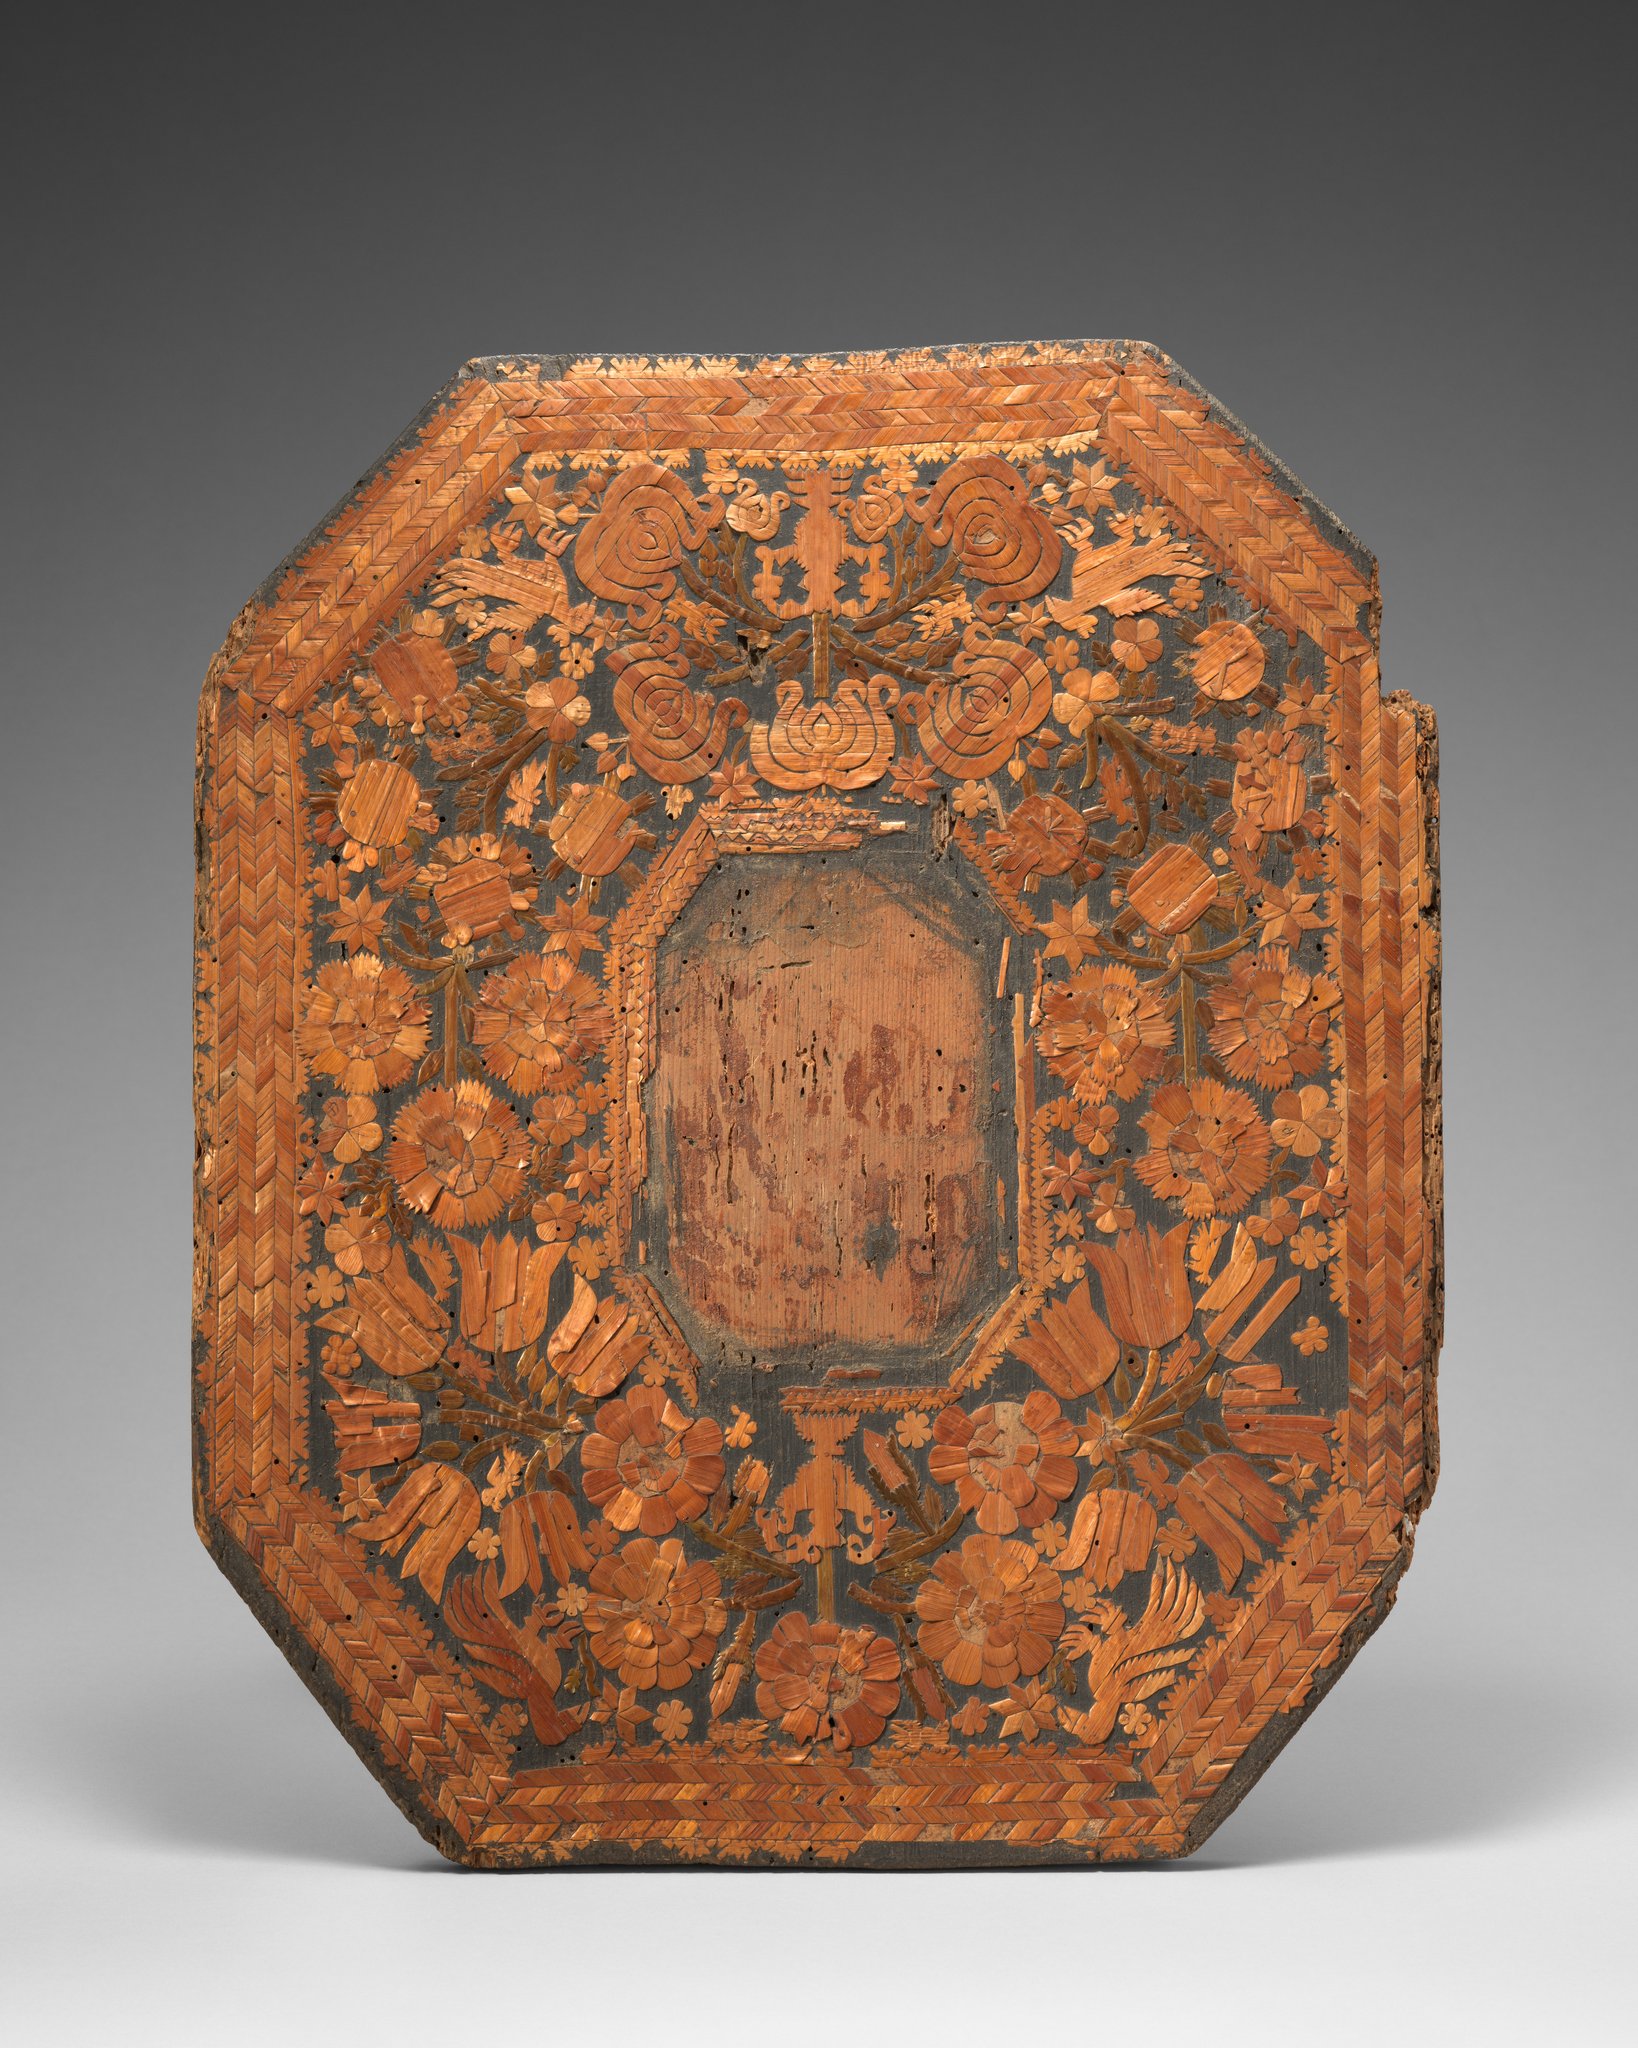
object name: box with cover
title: Box cover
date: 1701-1733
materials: paint, paper, fiber, wood